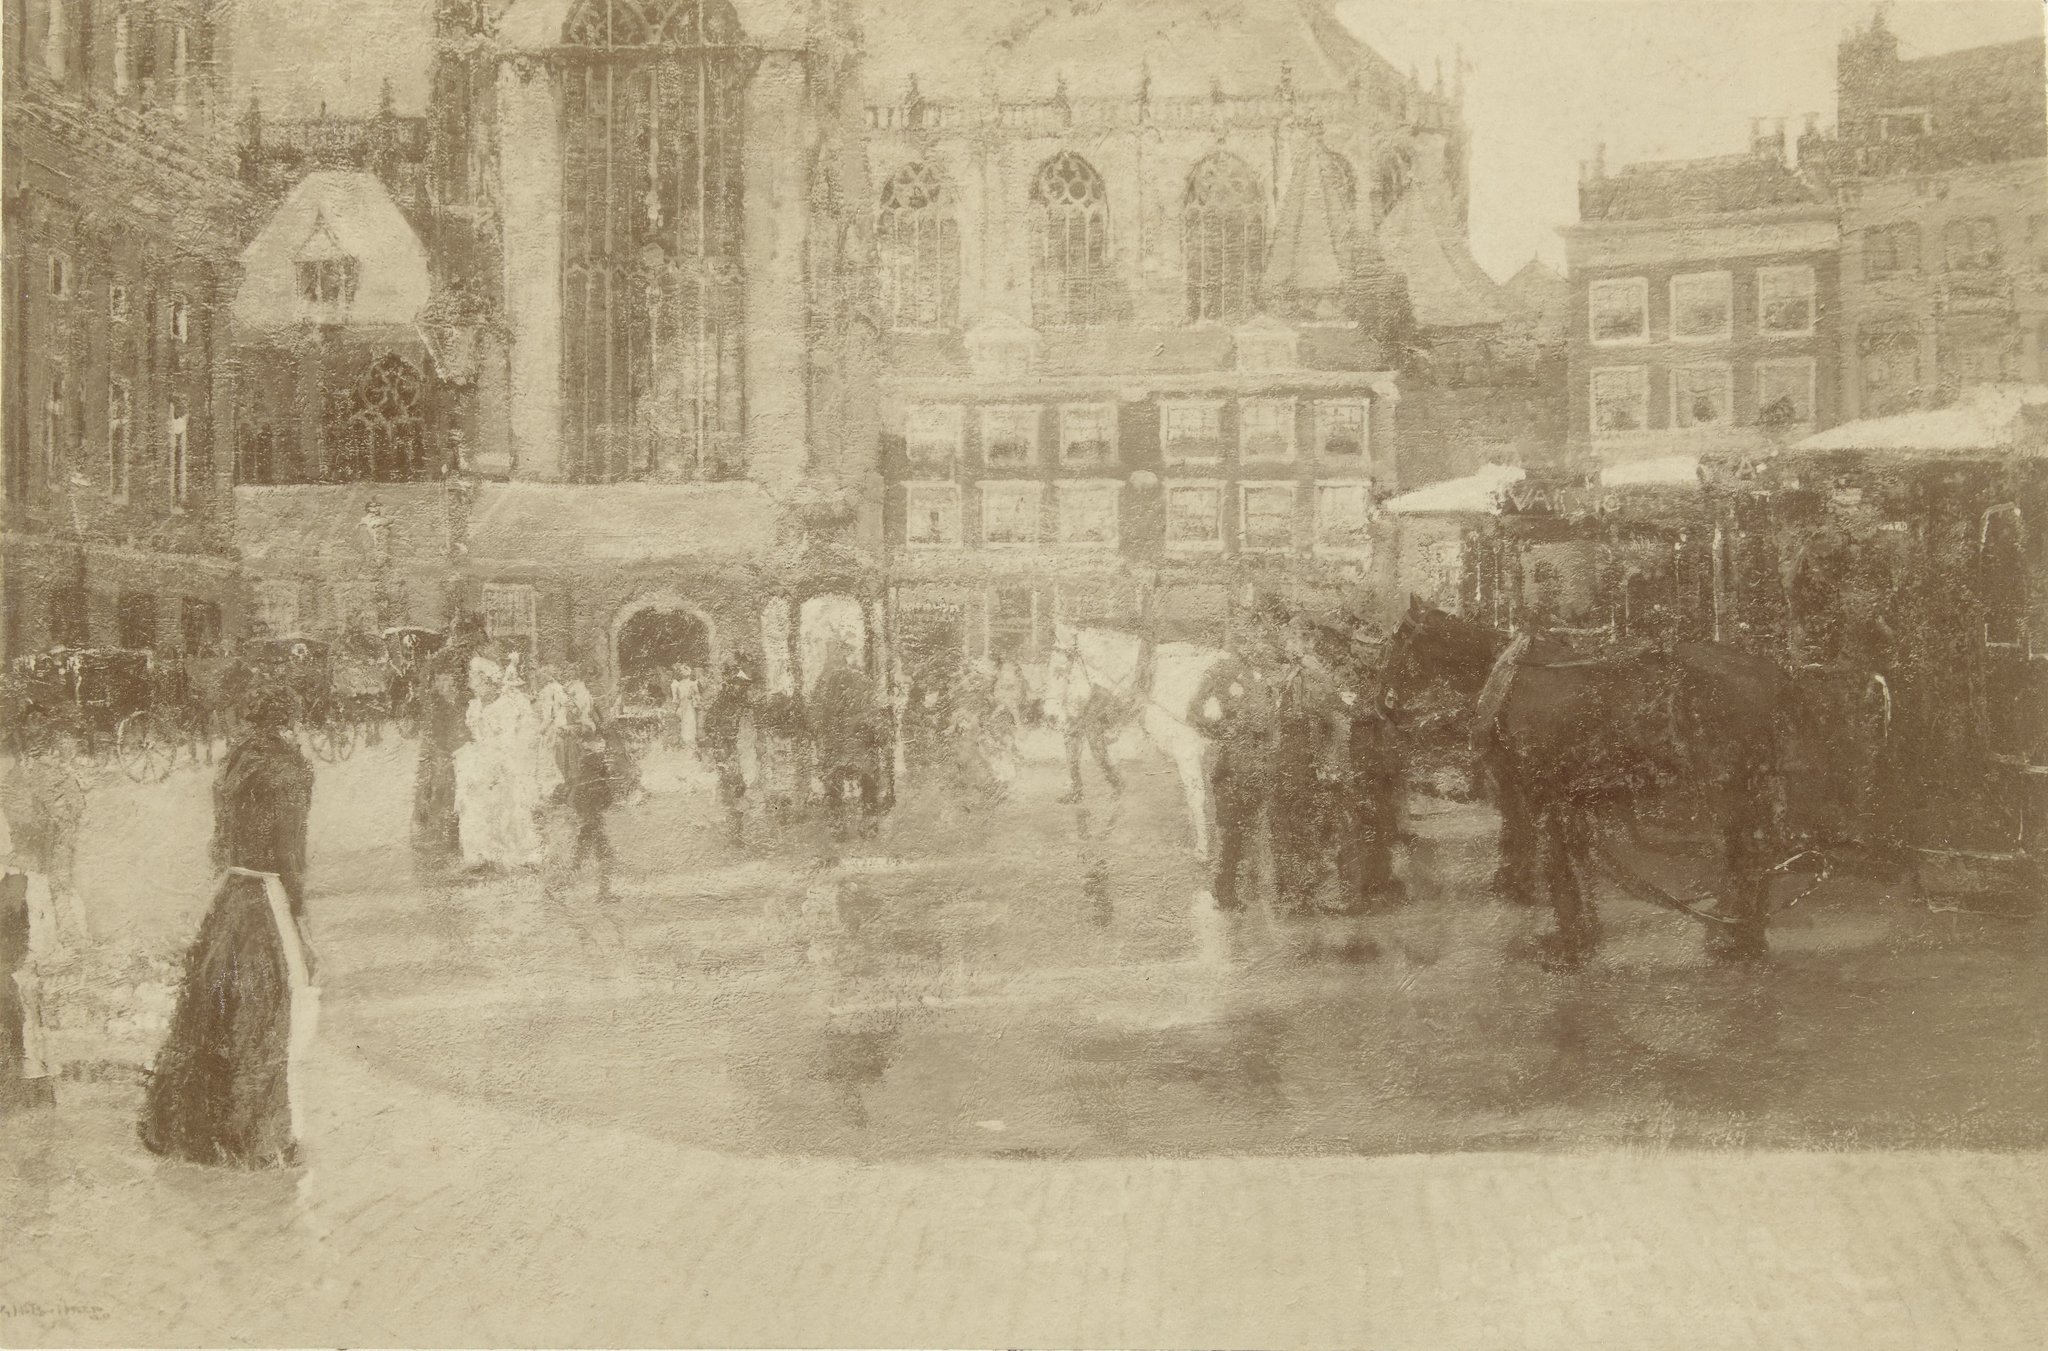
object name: photograph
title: Fotoreproductie van schilderij Dam met paardentram door George Hendrik Breitner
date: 1886-1910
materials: cardboard, paper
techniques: albumen print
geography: amsterdam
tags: picture, painting